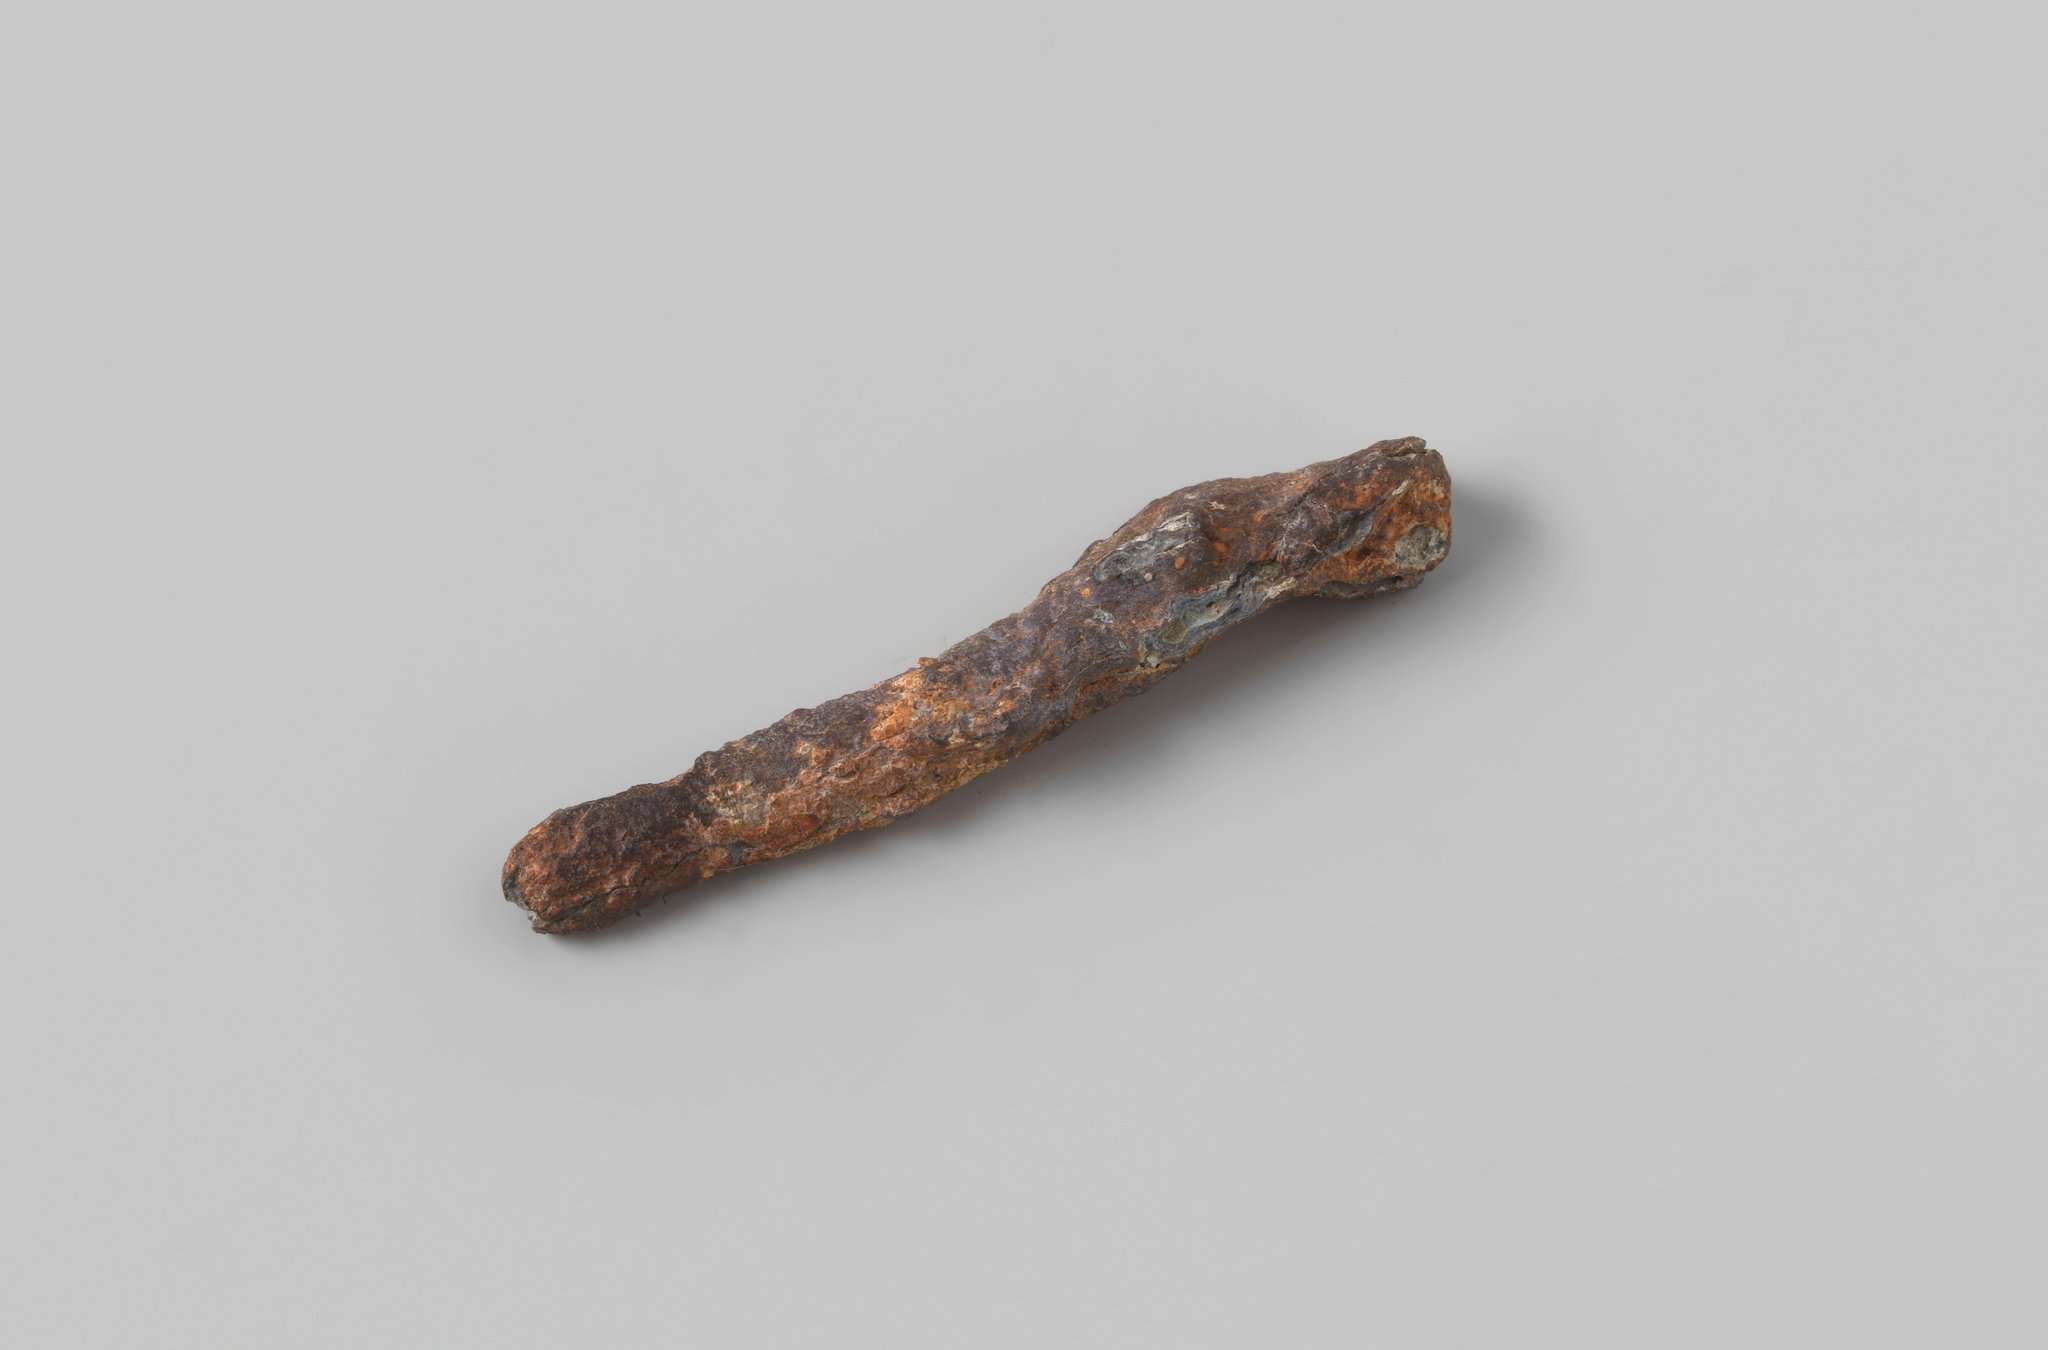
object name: cartridge shell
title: Beslag van patroonhuls uit het wrak van de Oost-Indiëvaarder Hollandia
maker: Anonymous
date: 1700-1743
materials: lead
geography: netherlands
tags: verenigde oostindische compagnie, hollandia (schip), annet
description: Cartridge case, tube solder; id. NG 1979-205H549.